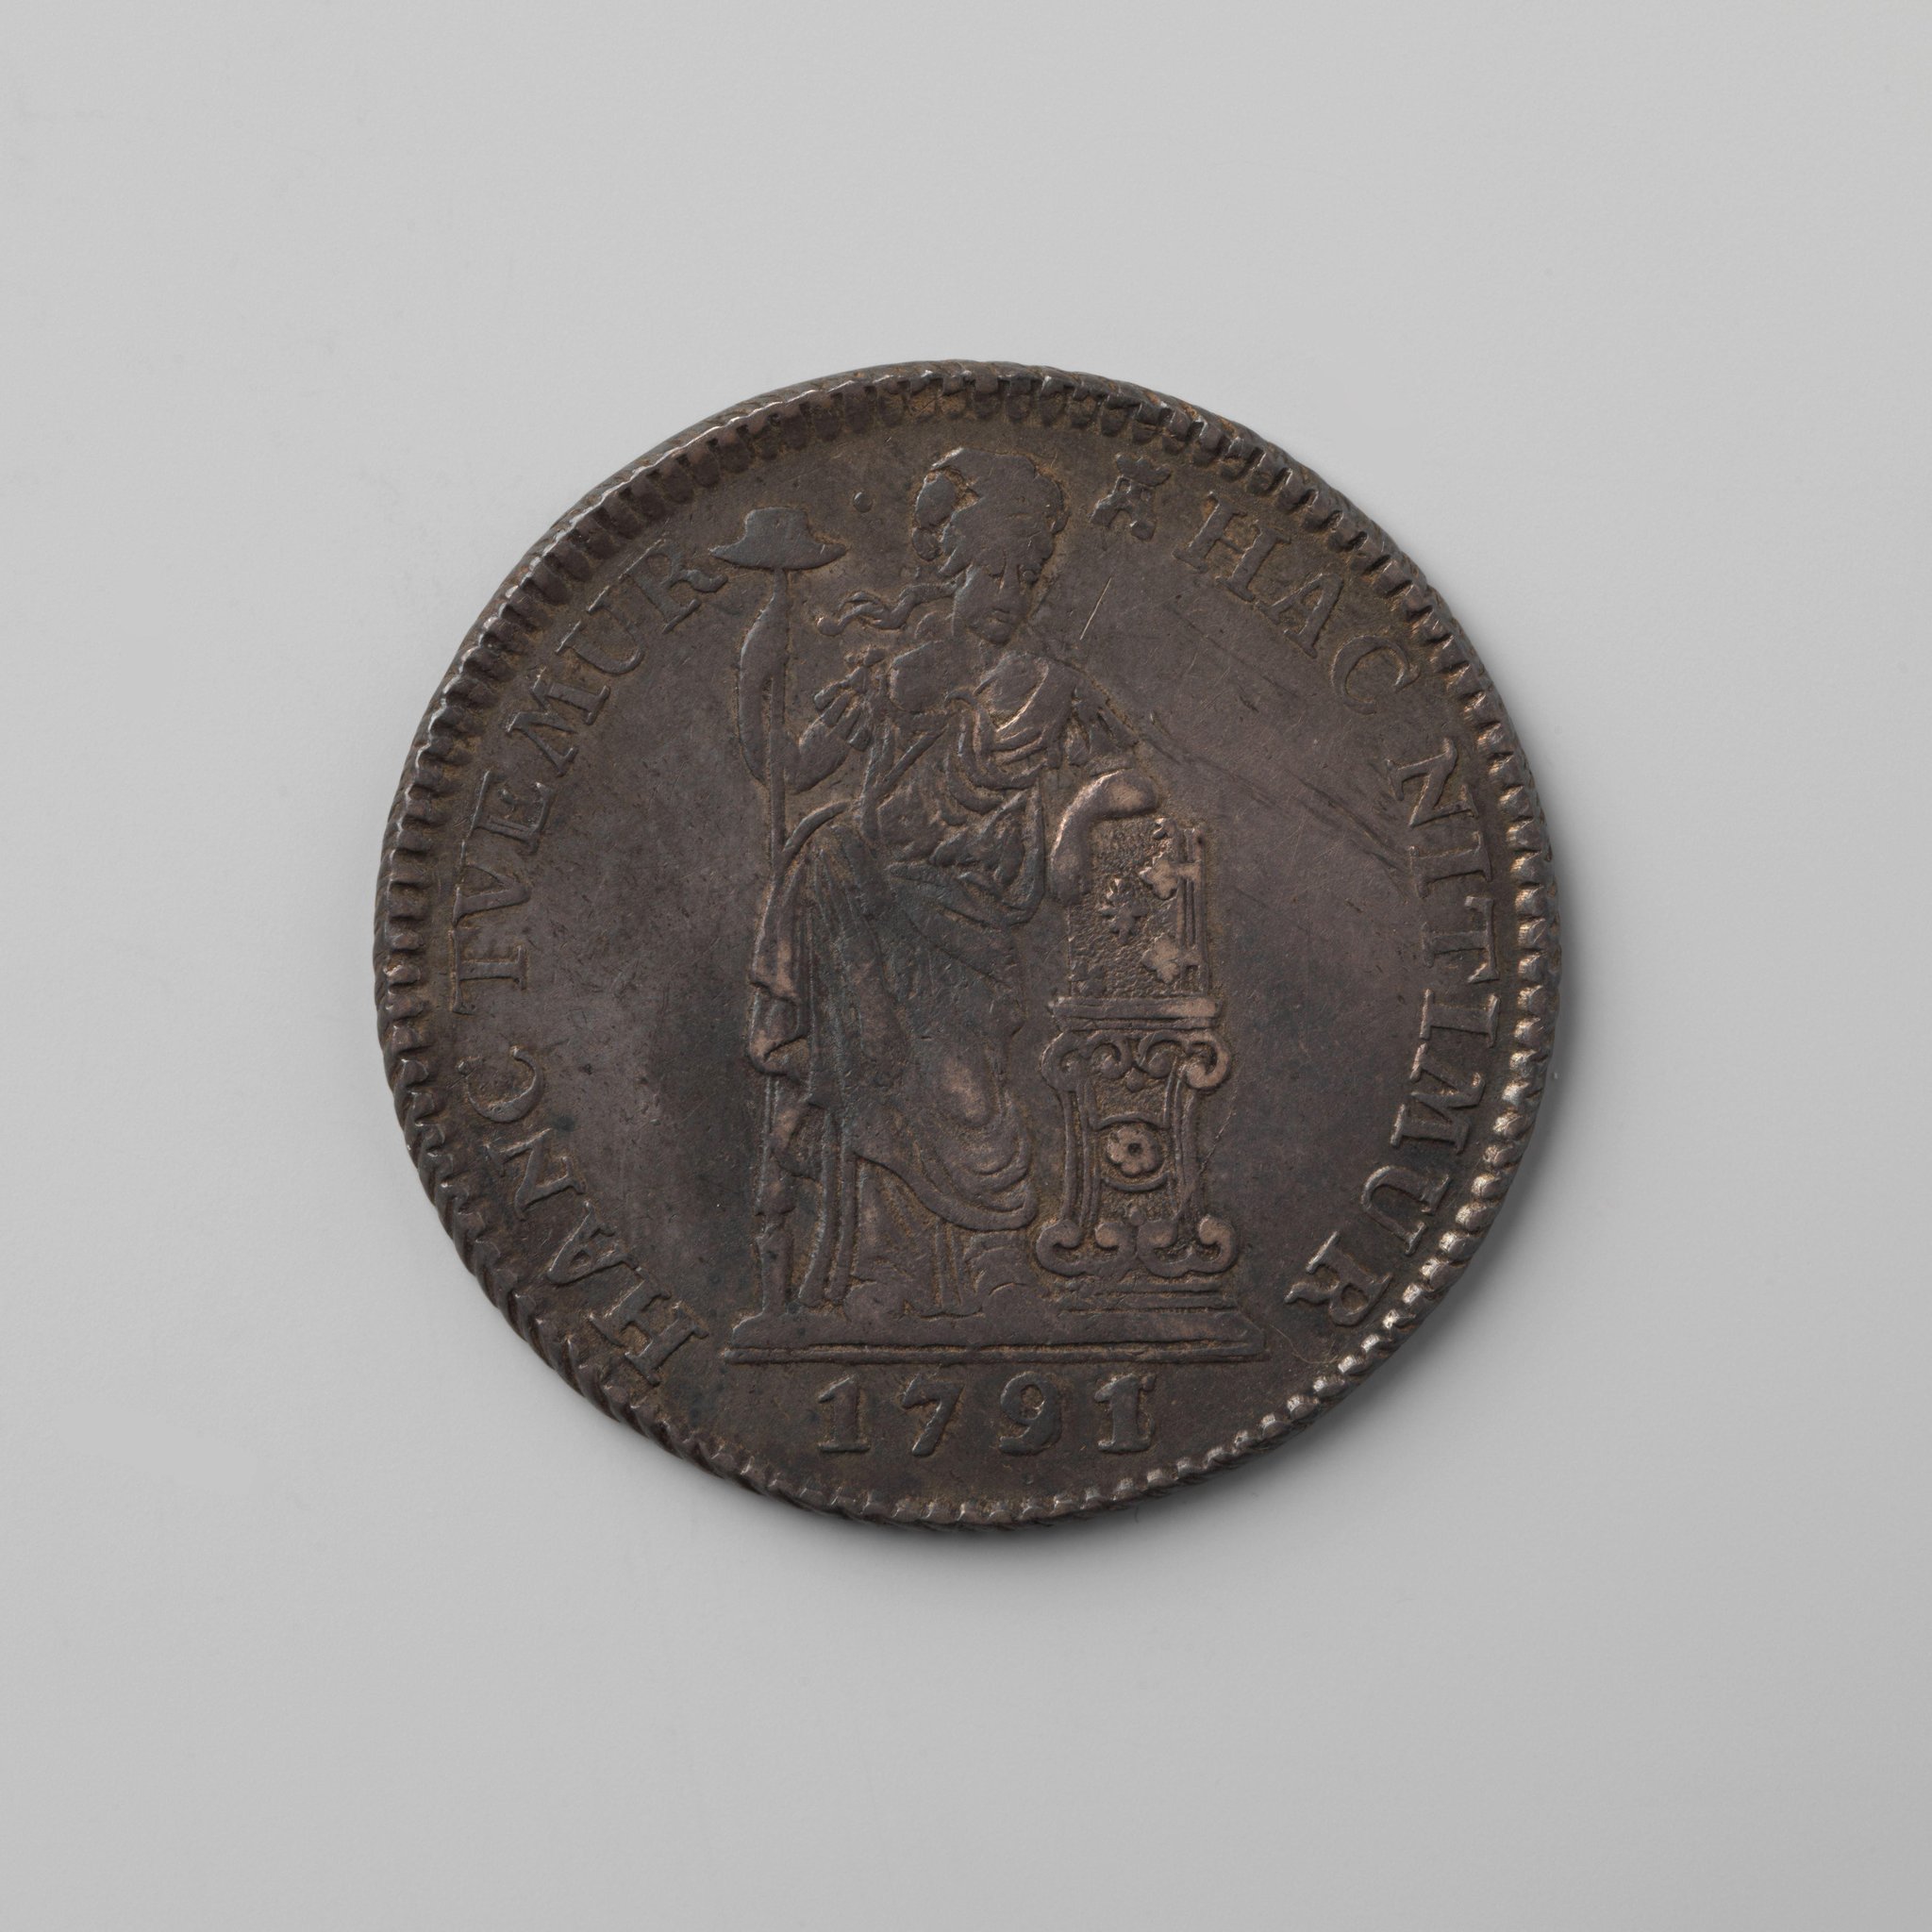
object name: coin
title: Gulden van de VOC uit Zeeland, 1791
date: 1791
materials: silver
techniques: striking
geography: middelburg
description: Zilveren munt. Voorzijde: tussen waarde-aanduiding I Gl. gekroond generaliteitswapenschild, waaronder cartouche, waarin monogram van de VOC. Keerzijde: Nederlandse maagd met speer, waarop vrijheidshoed, leunend op een bijbel op een altaar. Jaartal in afsnede. Kabelrand.